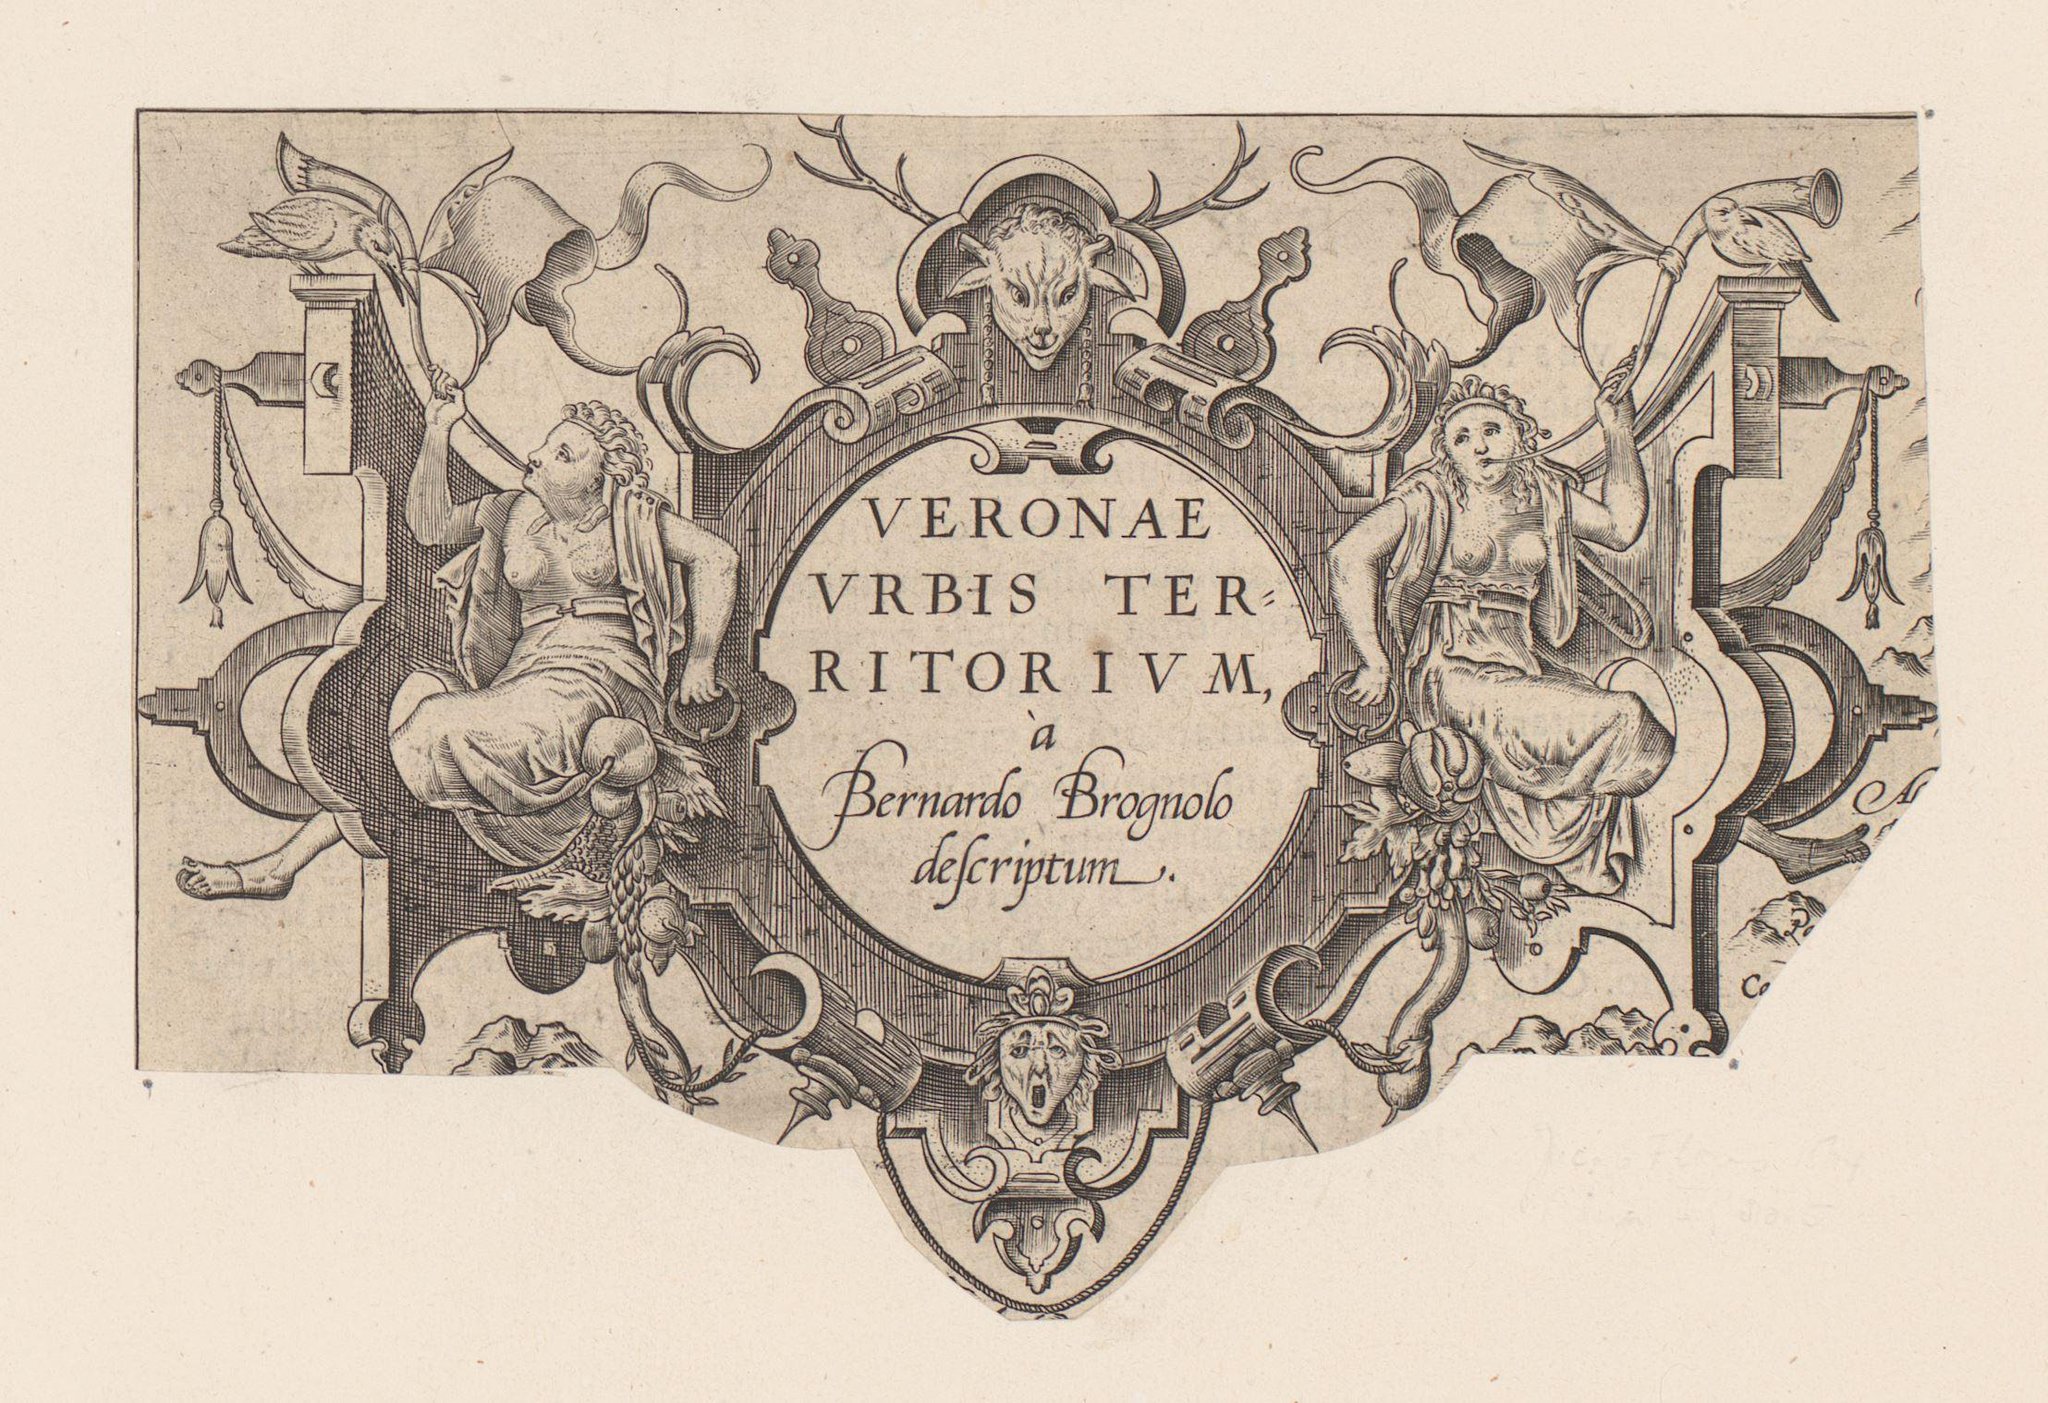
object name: ornament print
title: Veronae urbis territorium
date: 1589-1590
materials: paper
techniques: engraving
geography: antwerp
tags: ornament ~ cartouche, fame; 'fama', 'fama buona', 'fama chiara' (ripa)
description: Ronde rolwerkcartouche geflankeerd door twee vrouwen die blazen op een bazuin. Midden boven een hertenkop. De cartouche is een fragment van een kaart van het grondgebied van Verona. De prent maakt deel uit van een album.